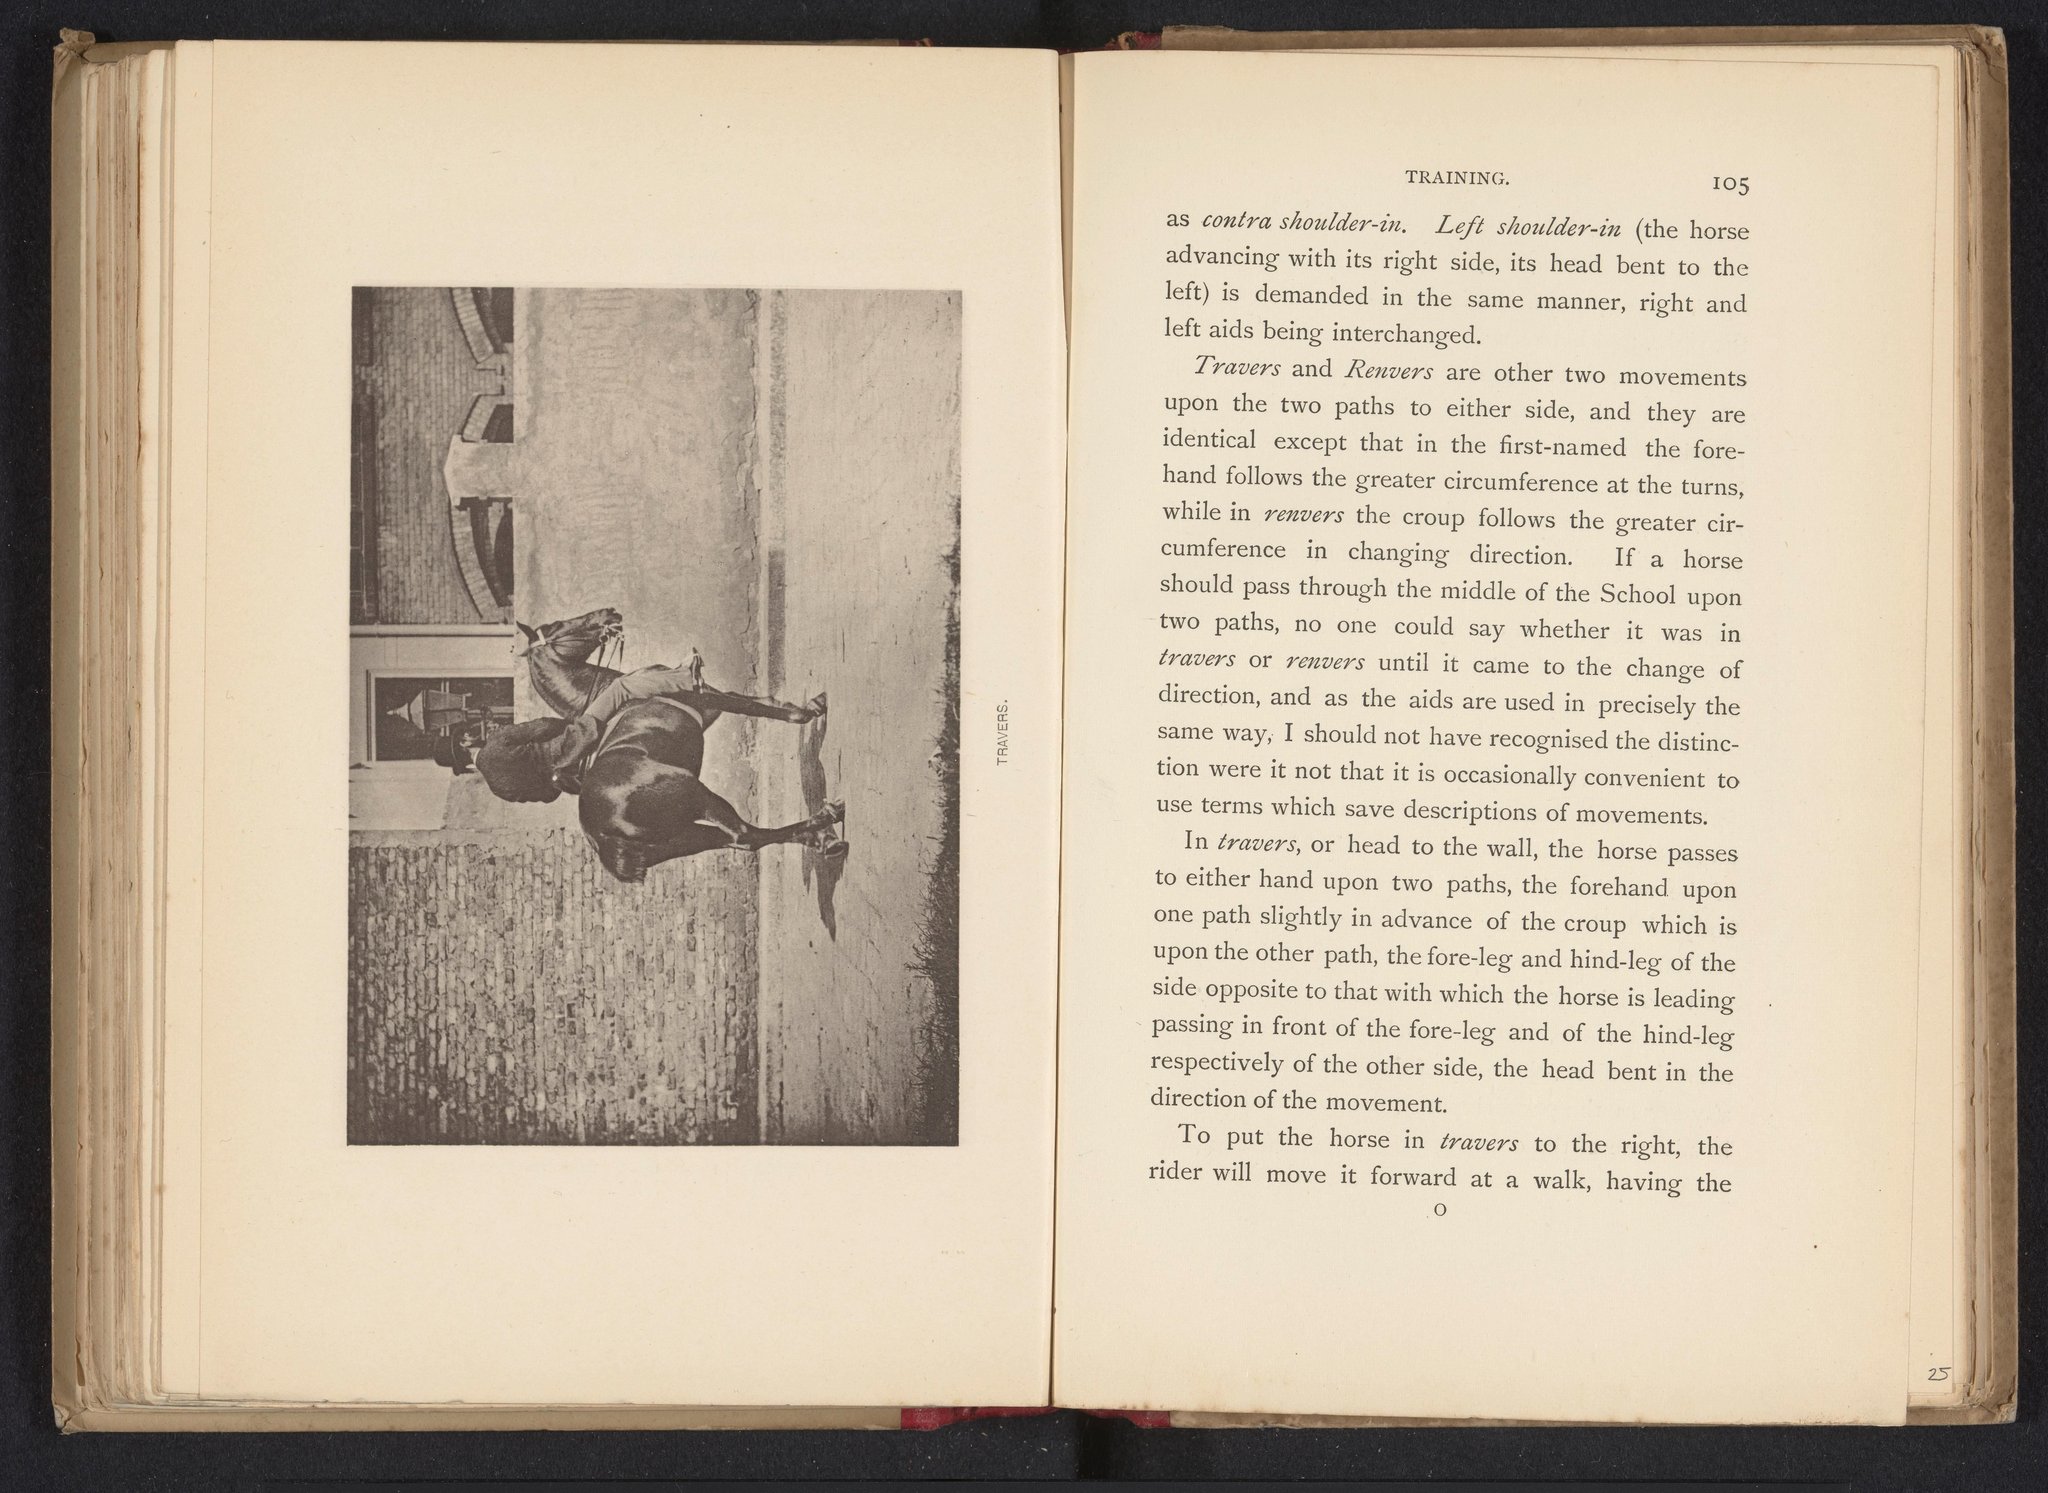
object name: page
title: Travers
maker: alexander nicol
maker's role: fotograaf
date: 1879-1889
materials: paper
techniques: photograph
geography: edinburgh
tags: riding a horse, ass, or mule; rider, horseman, head-gear: bowler hat, horse